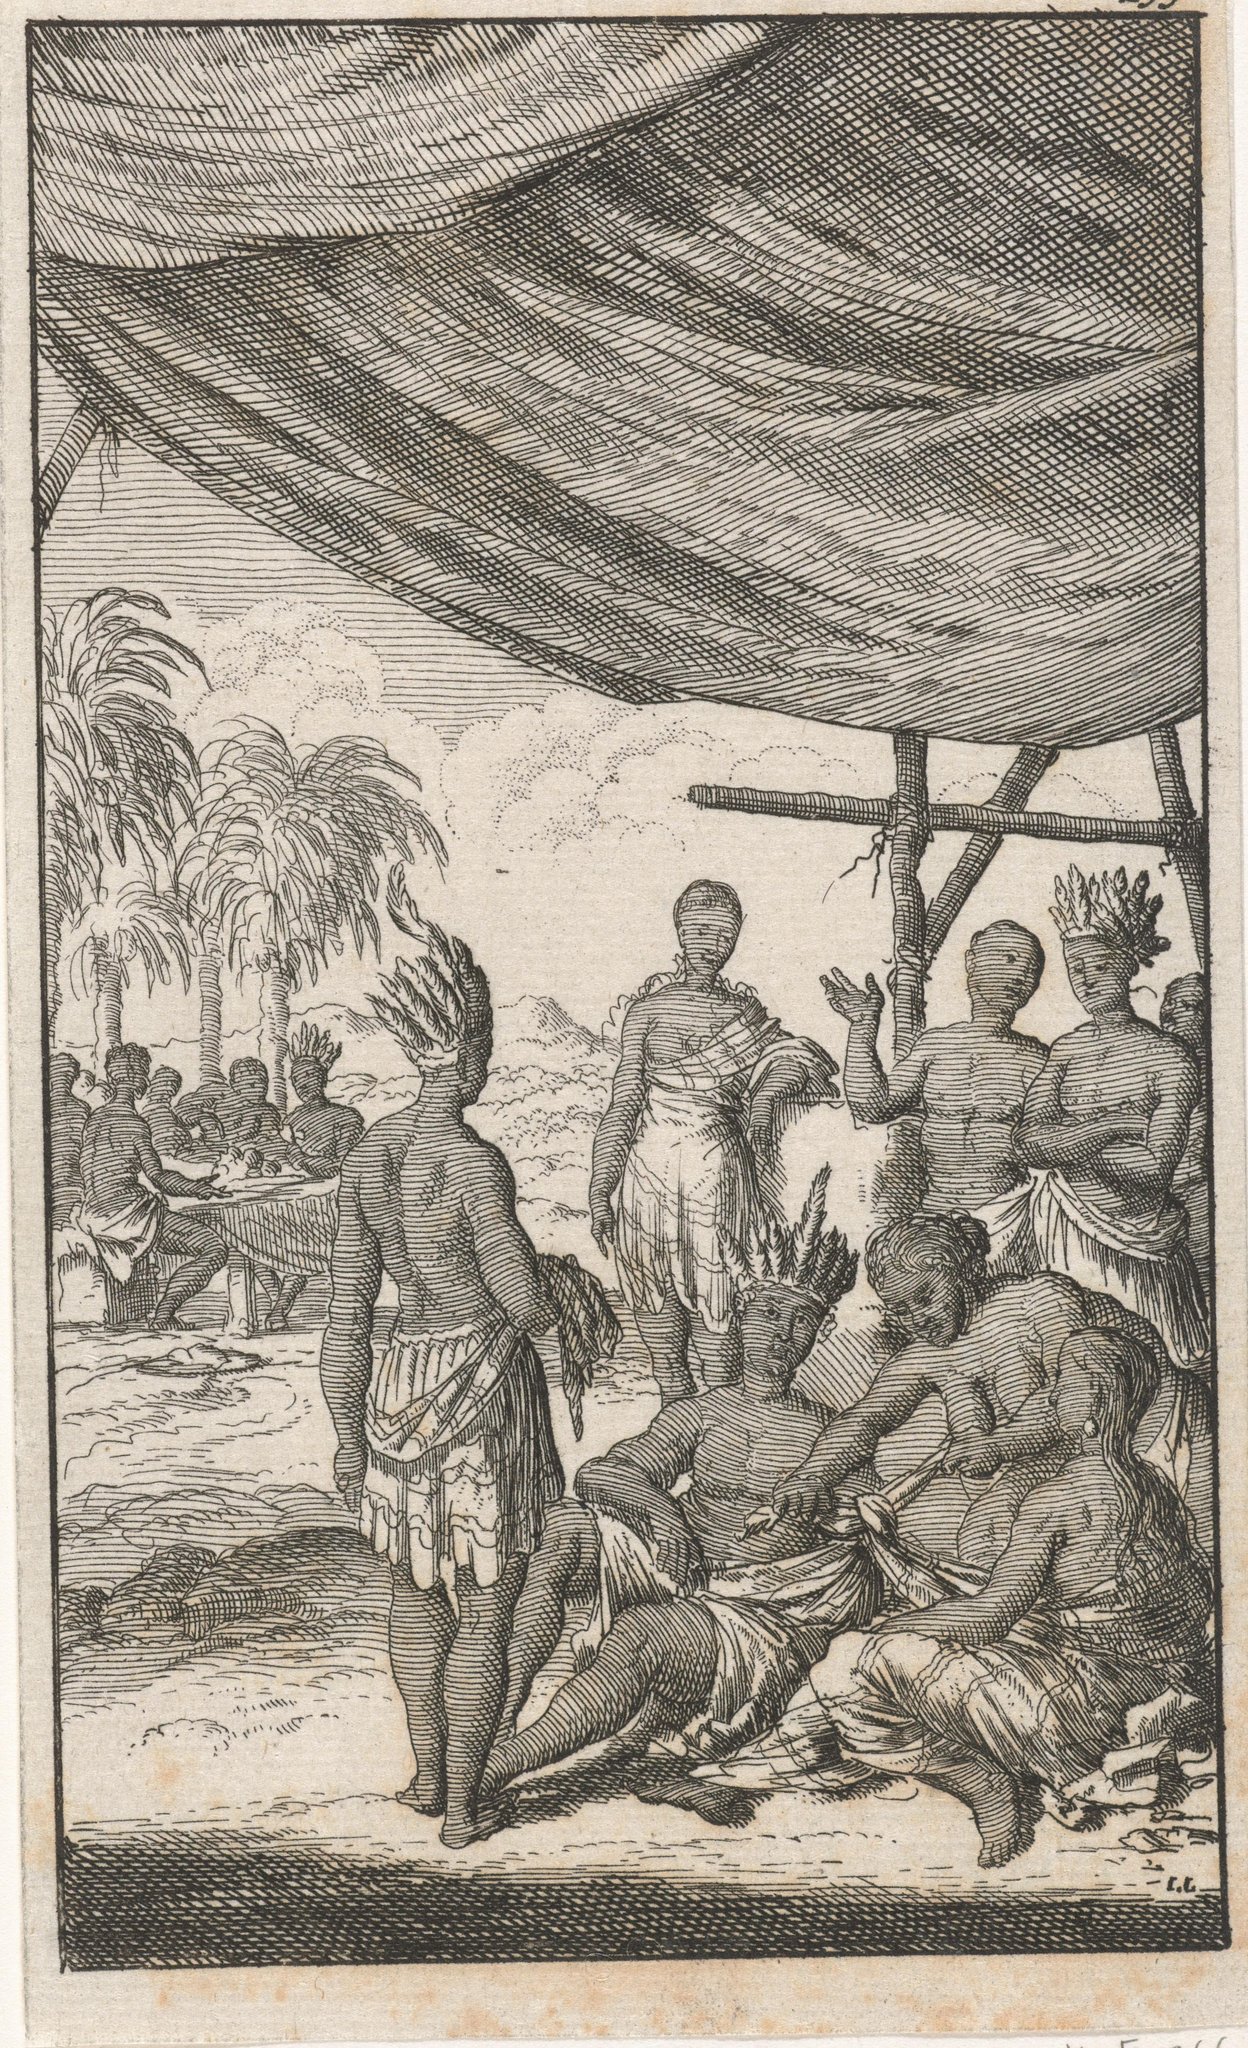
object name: book illustration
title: Huwelijk onder de Mexicanen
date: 1681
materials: paper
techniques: etching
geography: amsterdam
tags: (civil) marriage ceremonies, indigenous peoples of central america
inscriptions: collector's mark: Lugt 2228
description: Illustratie opgenomen in: Neyn, Pieter de. Lust-hof der huwelyken, behelsende verscheyde seldsame ceremonien (...) by verscheyde natien. Amsterdam: Jan Bouman, 1681.